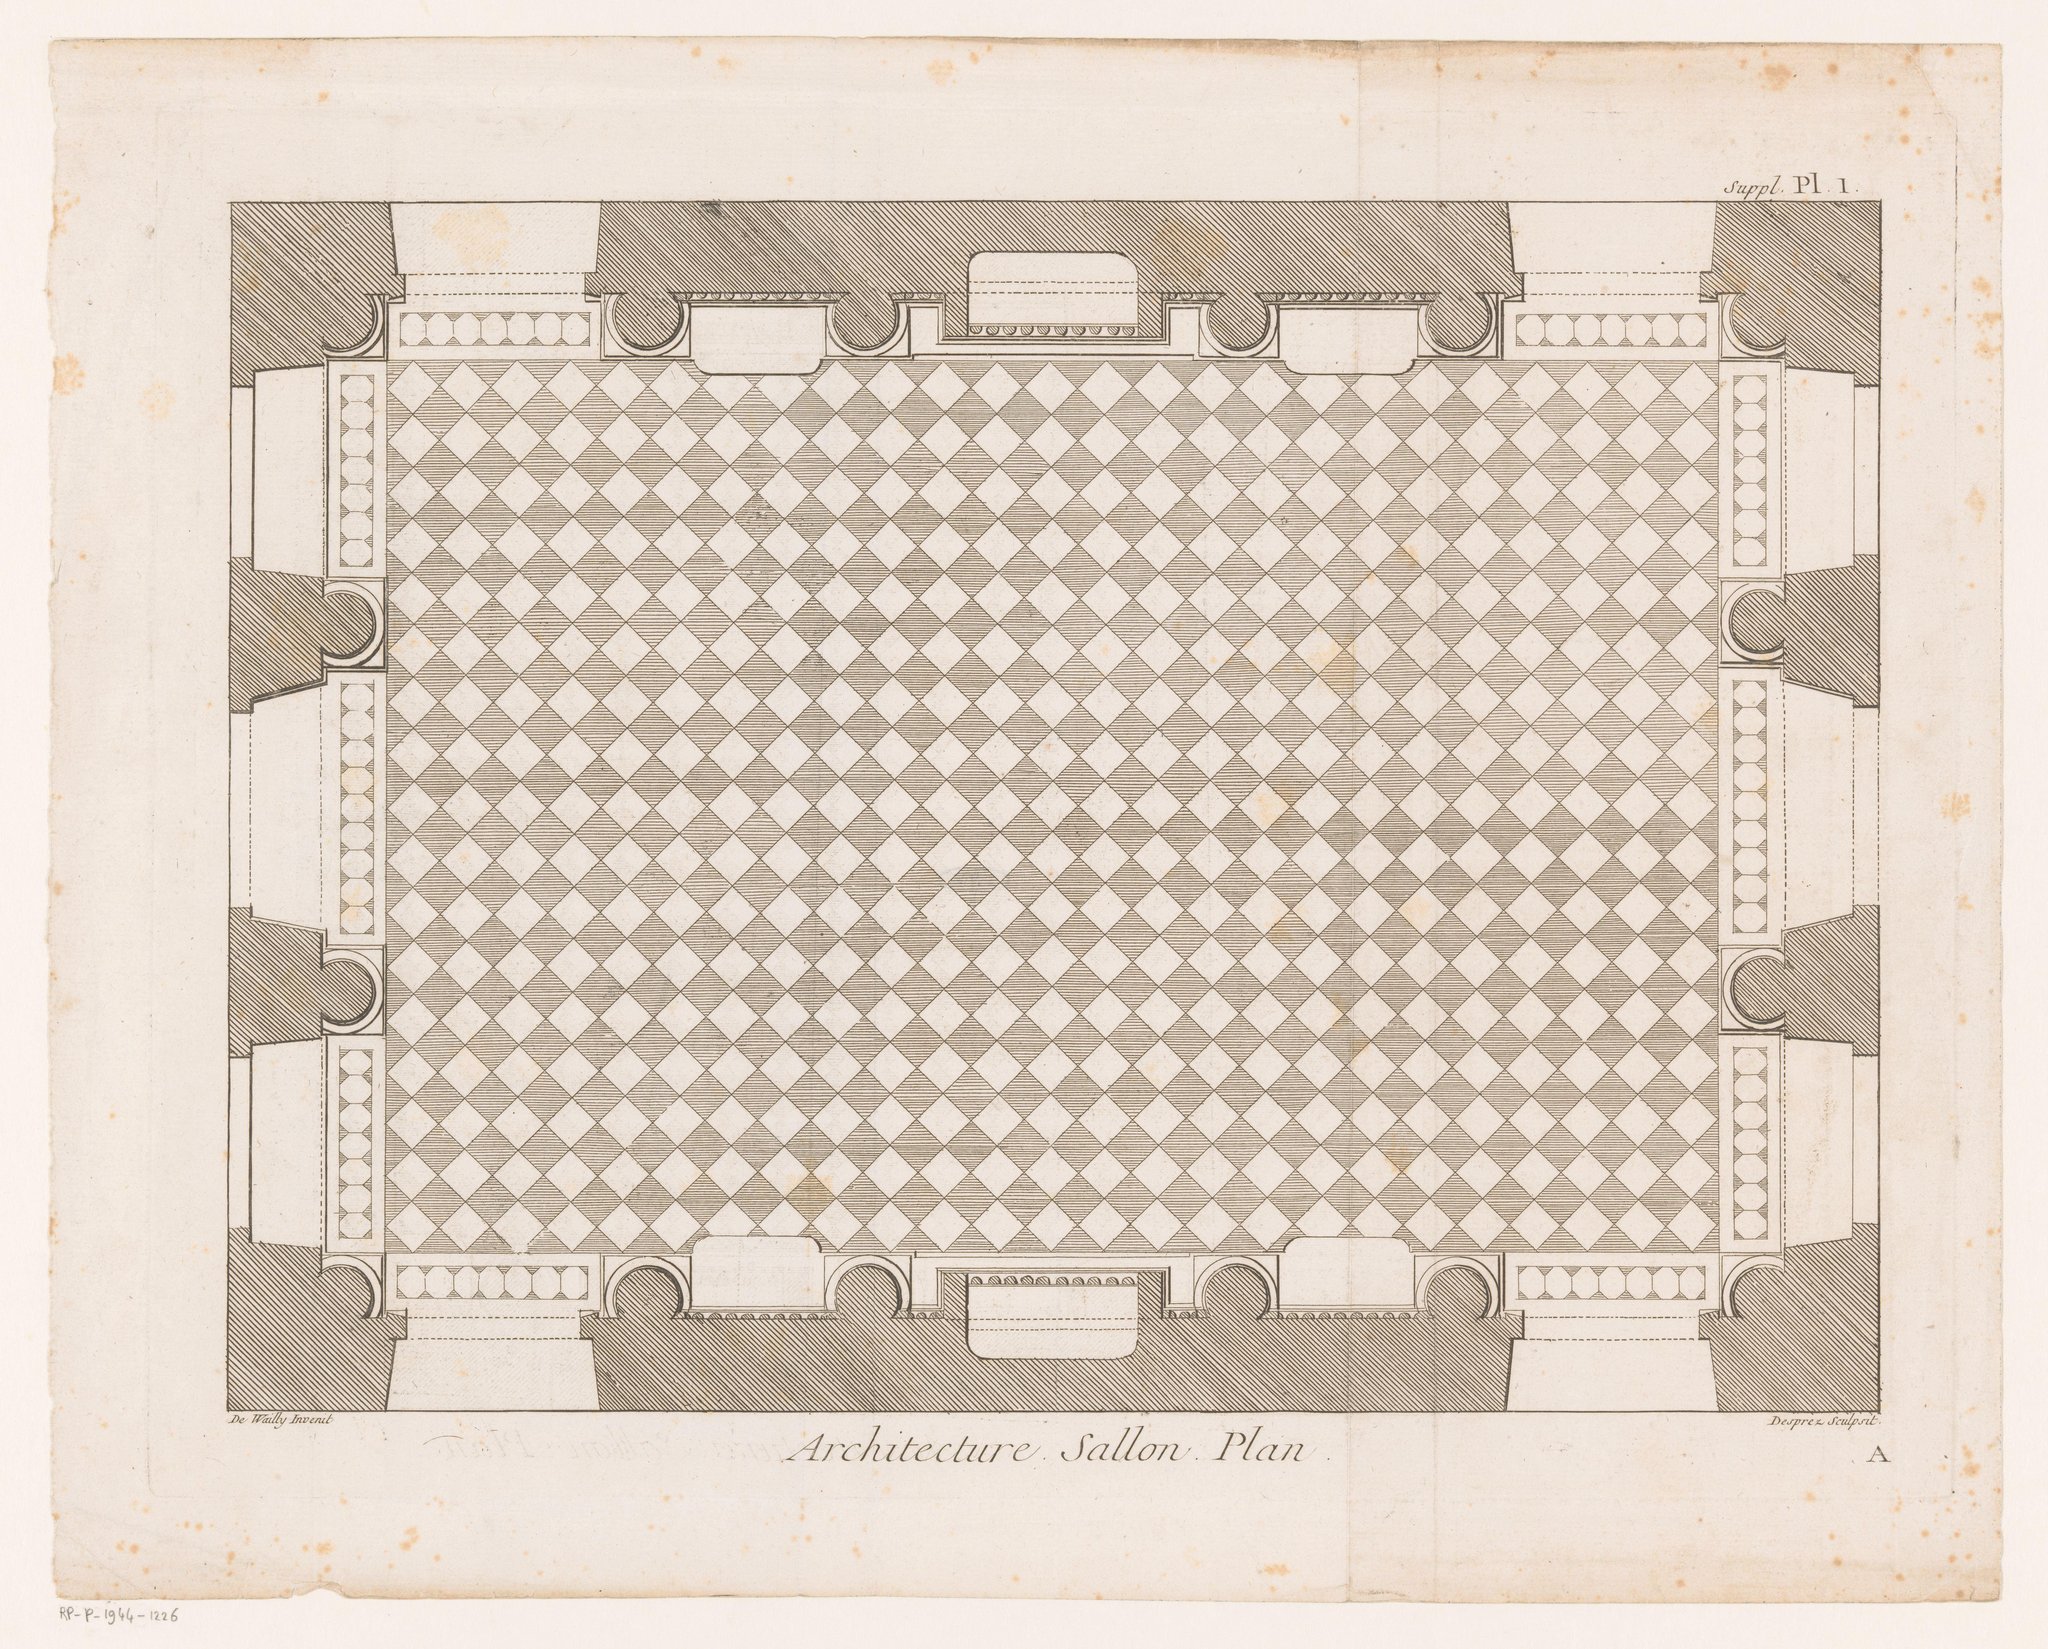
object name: print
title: Plattegrond van een zaal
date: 1753-1804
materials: paper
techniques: etching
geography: france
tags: plan ~ architecture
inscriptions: collector's mark: Lugt 2228